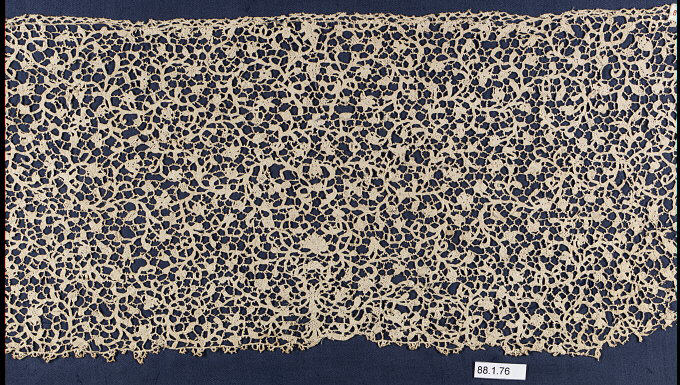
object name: fragment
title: Fragment of lace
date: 1701-1800